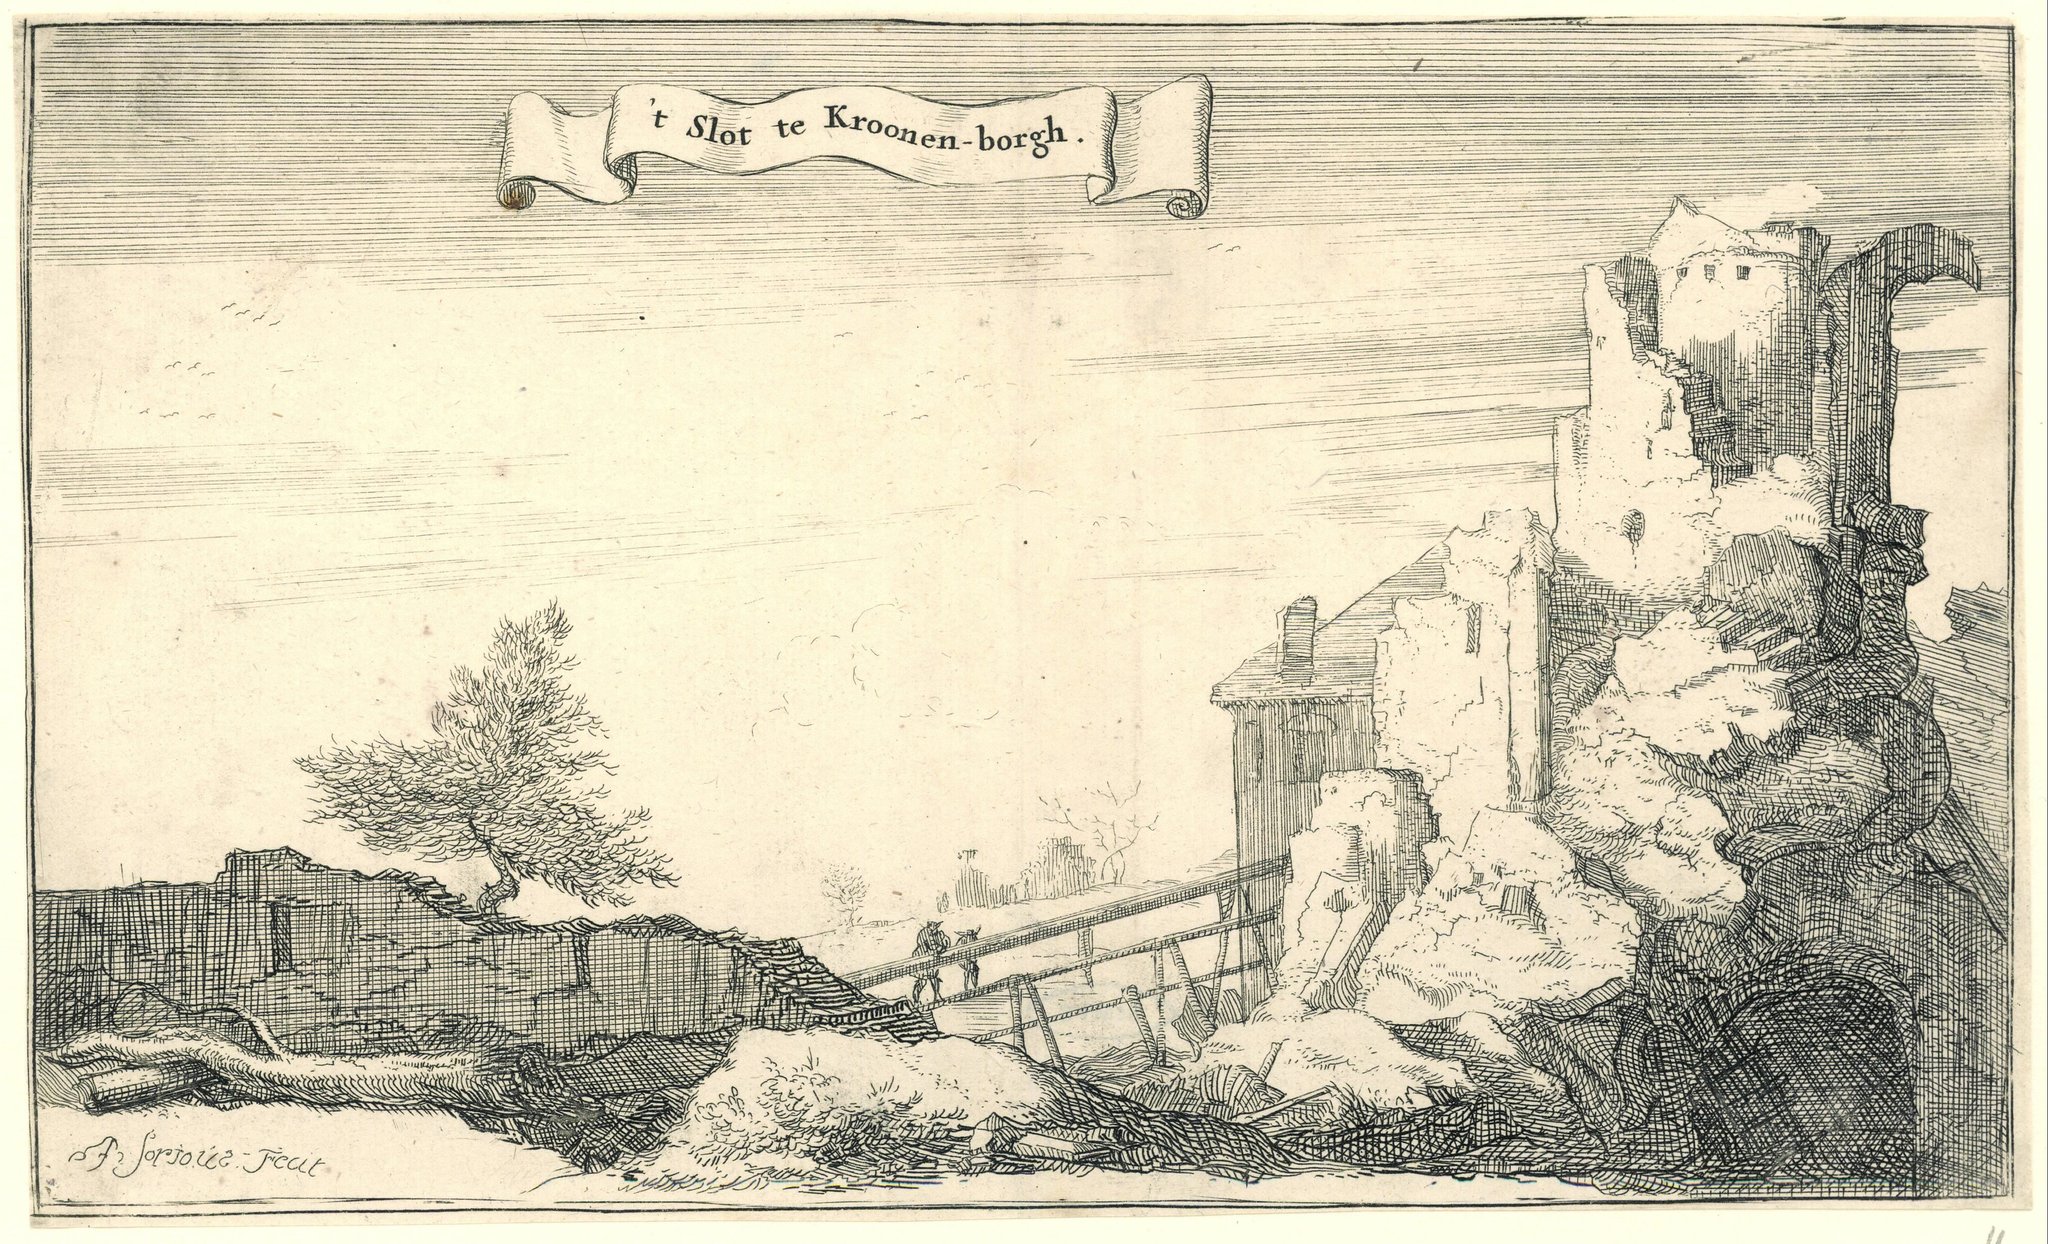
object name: history print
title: Reeks van dertien afbeeldingen van de dorpen en kastelen in de provincie Utrecht door de Fransen in 1672 verwoest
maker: isaac sorious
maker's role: print maker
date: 1672-1676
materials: paper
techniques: engraving, etching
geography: northern netherlands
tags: devastated, ruined place or city (~ warfare), rampjaar (disaster year)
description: Gebruikt als illustratie in: T. van Domselaer, Het Ontroerde Nederlandt, dl. II, Marcus Willemsz Doornick, Amsterdam 1676, p. 400/401. De reeks is ook als een losse serie uitgegeven met een titelprent die niet in het boek is opgenomen.